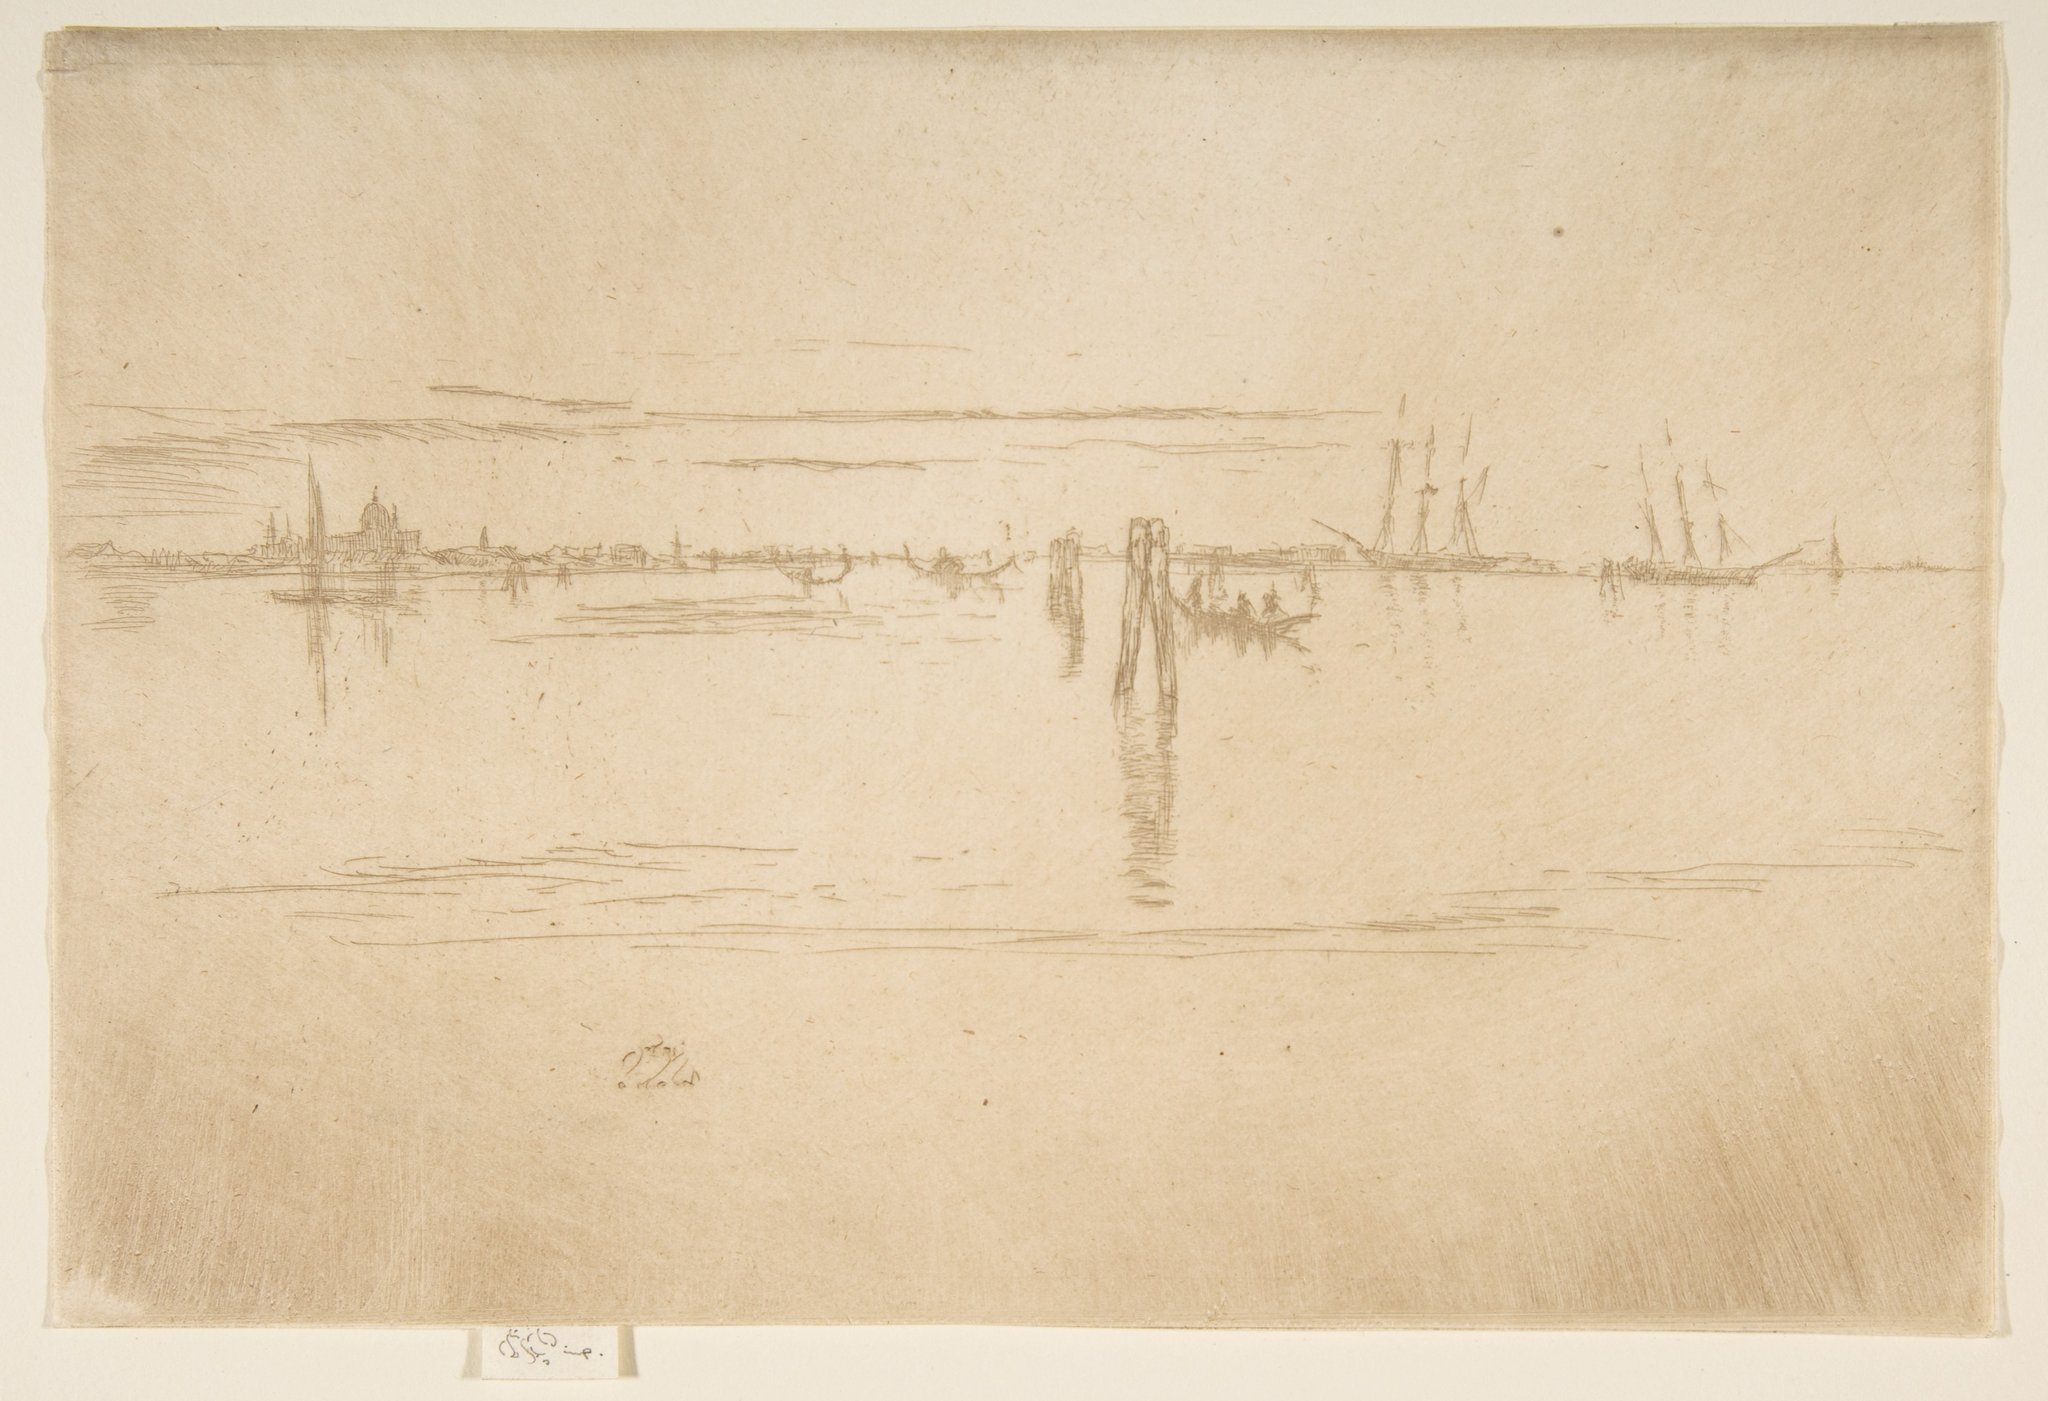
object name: print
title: Long Lagoon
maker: james mcneill whistler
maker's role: artist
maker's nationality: american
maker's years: 1834-1903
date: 1879-1880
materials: ink, paper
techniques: drypoint, etching, printing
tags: boats,venice